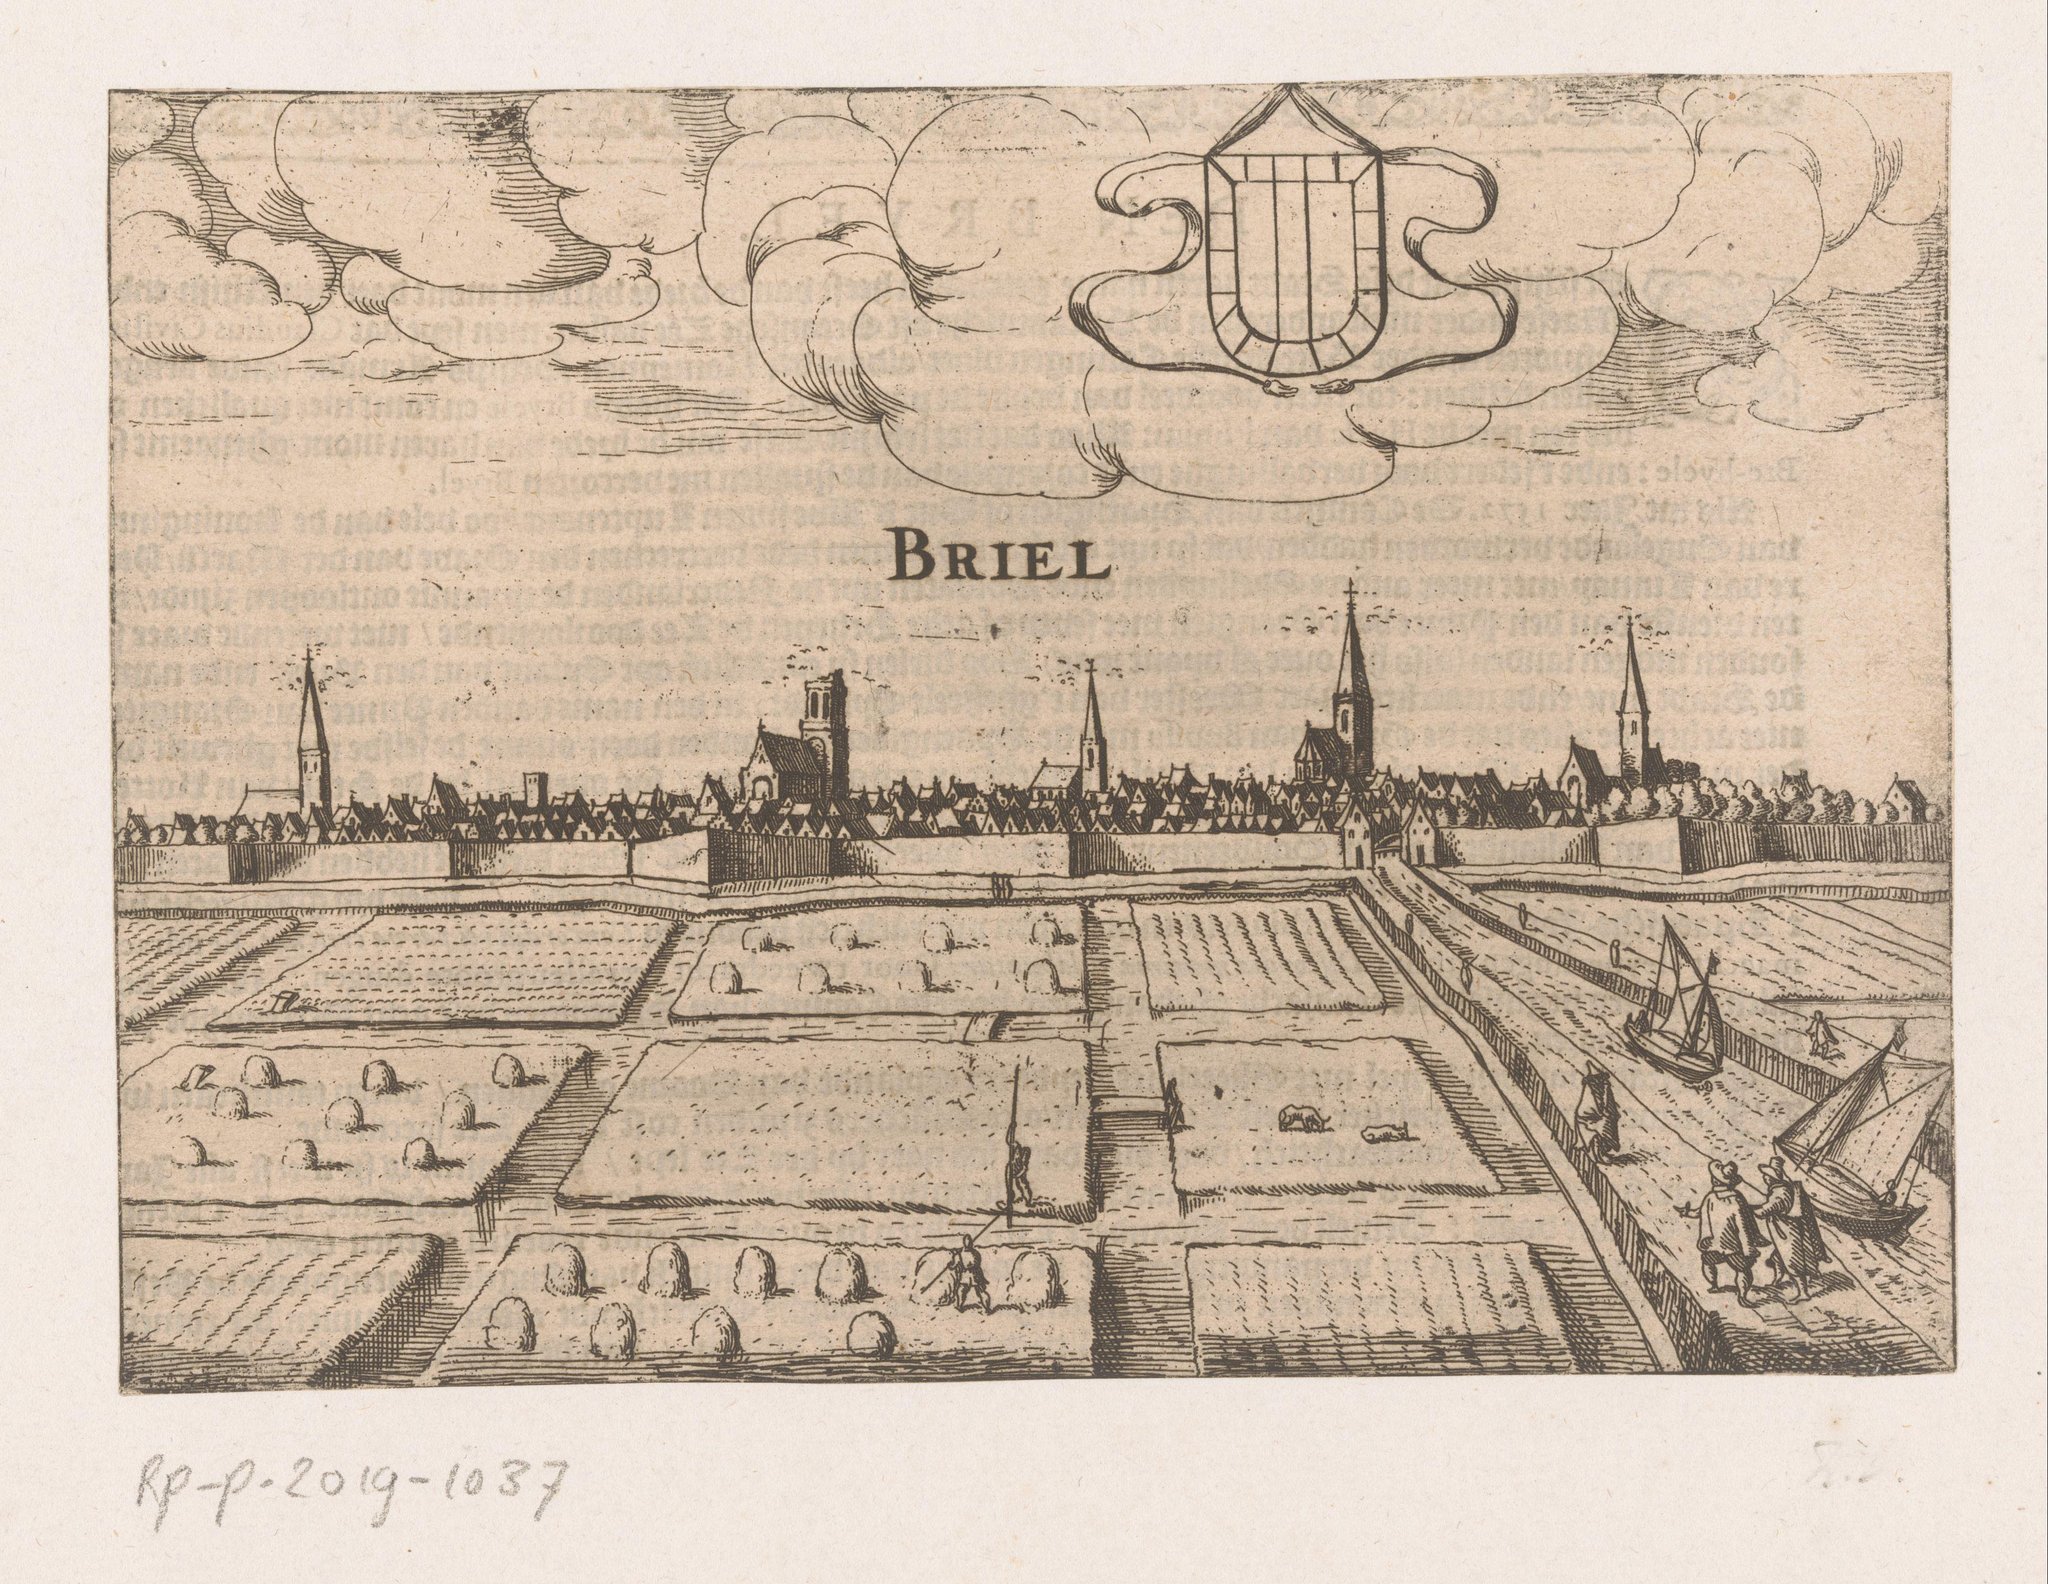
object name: print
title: Briel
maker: Anonymous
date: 1615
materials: paper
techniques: etching, letterpress printing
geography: low countries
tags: prospect of city, town panorama, silhouette of city (+ city(-scape) with figures, staffage), brielle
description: Prent uit: Petit, Jean François le. Nederlantsche Republycke (...). Arnhem: s.n., 1615, p. 135.